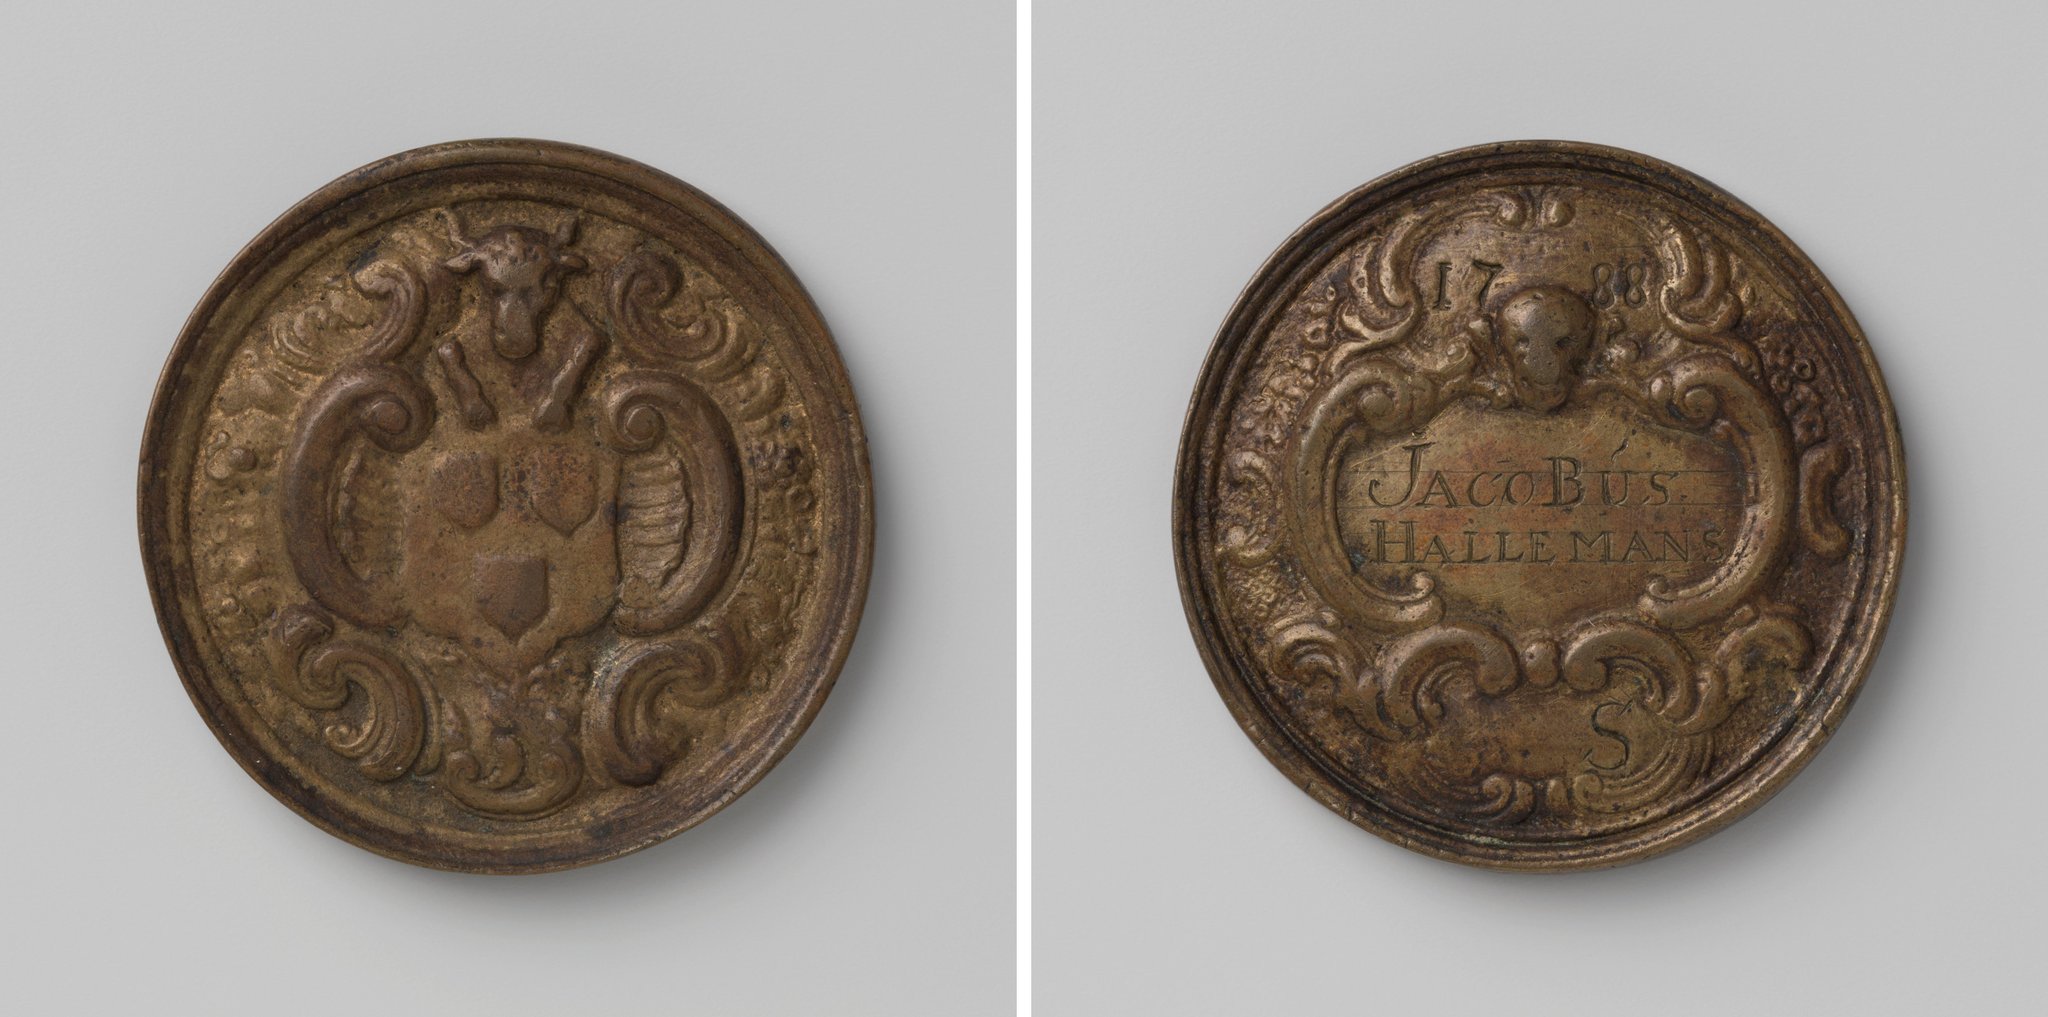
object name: medal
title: St. Lucasgilde van Amsterdam, gildepenning van Jacobus Hallemans, schilder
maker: Anonymous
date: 1788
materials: brass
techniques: casting, engraving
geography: amsterdam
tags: amsterdam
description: Messing penning. Voorzijde: os houdt Lucasschild in zijn poten; daaromheen lofwerk. Keerzijde: cartouche met opschrift onder dierenkop, en cartouche met jaartal, boven cartouche met letter S